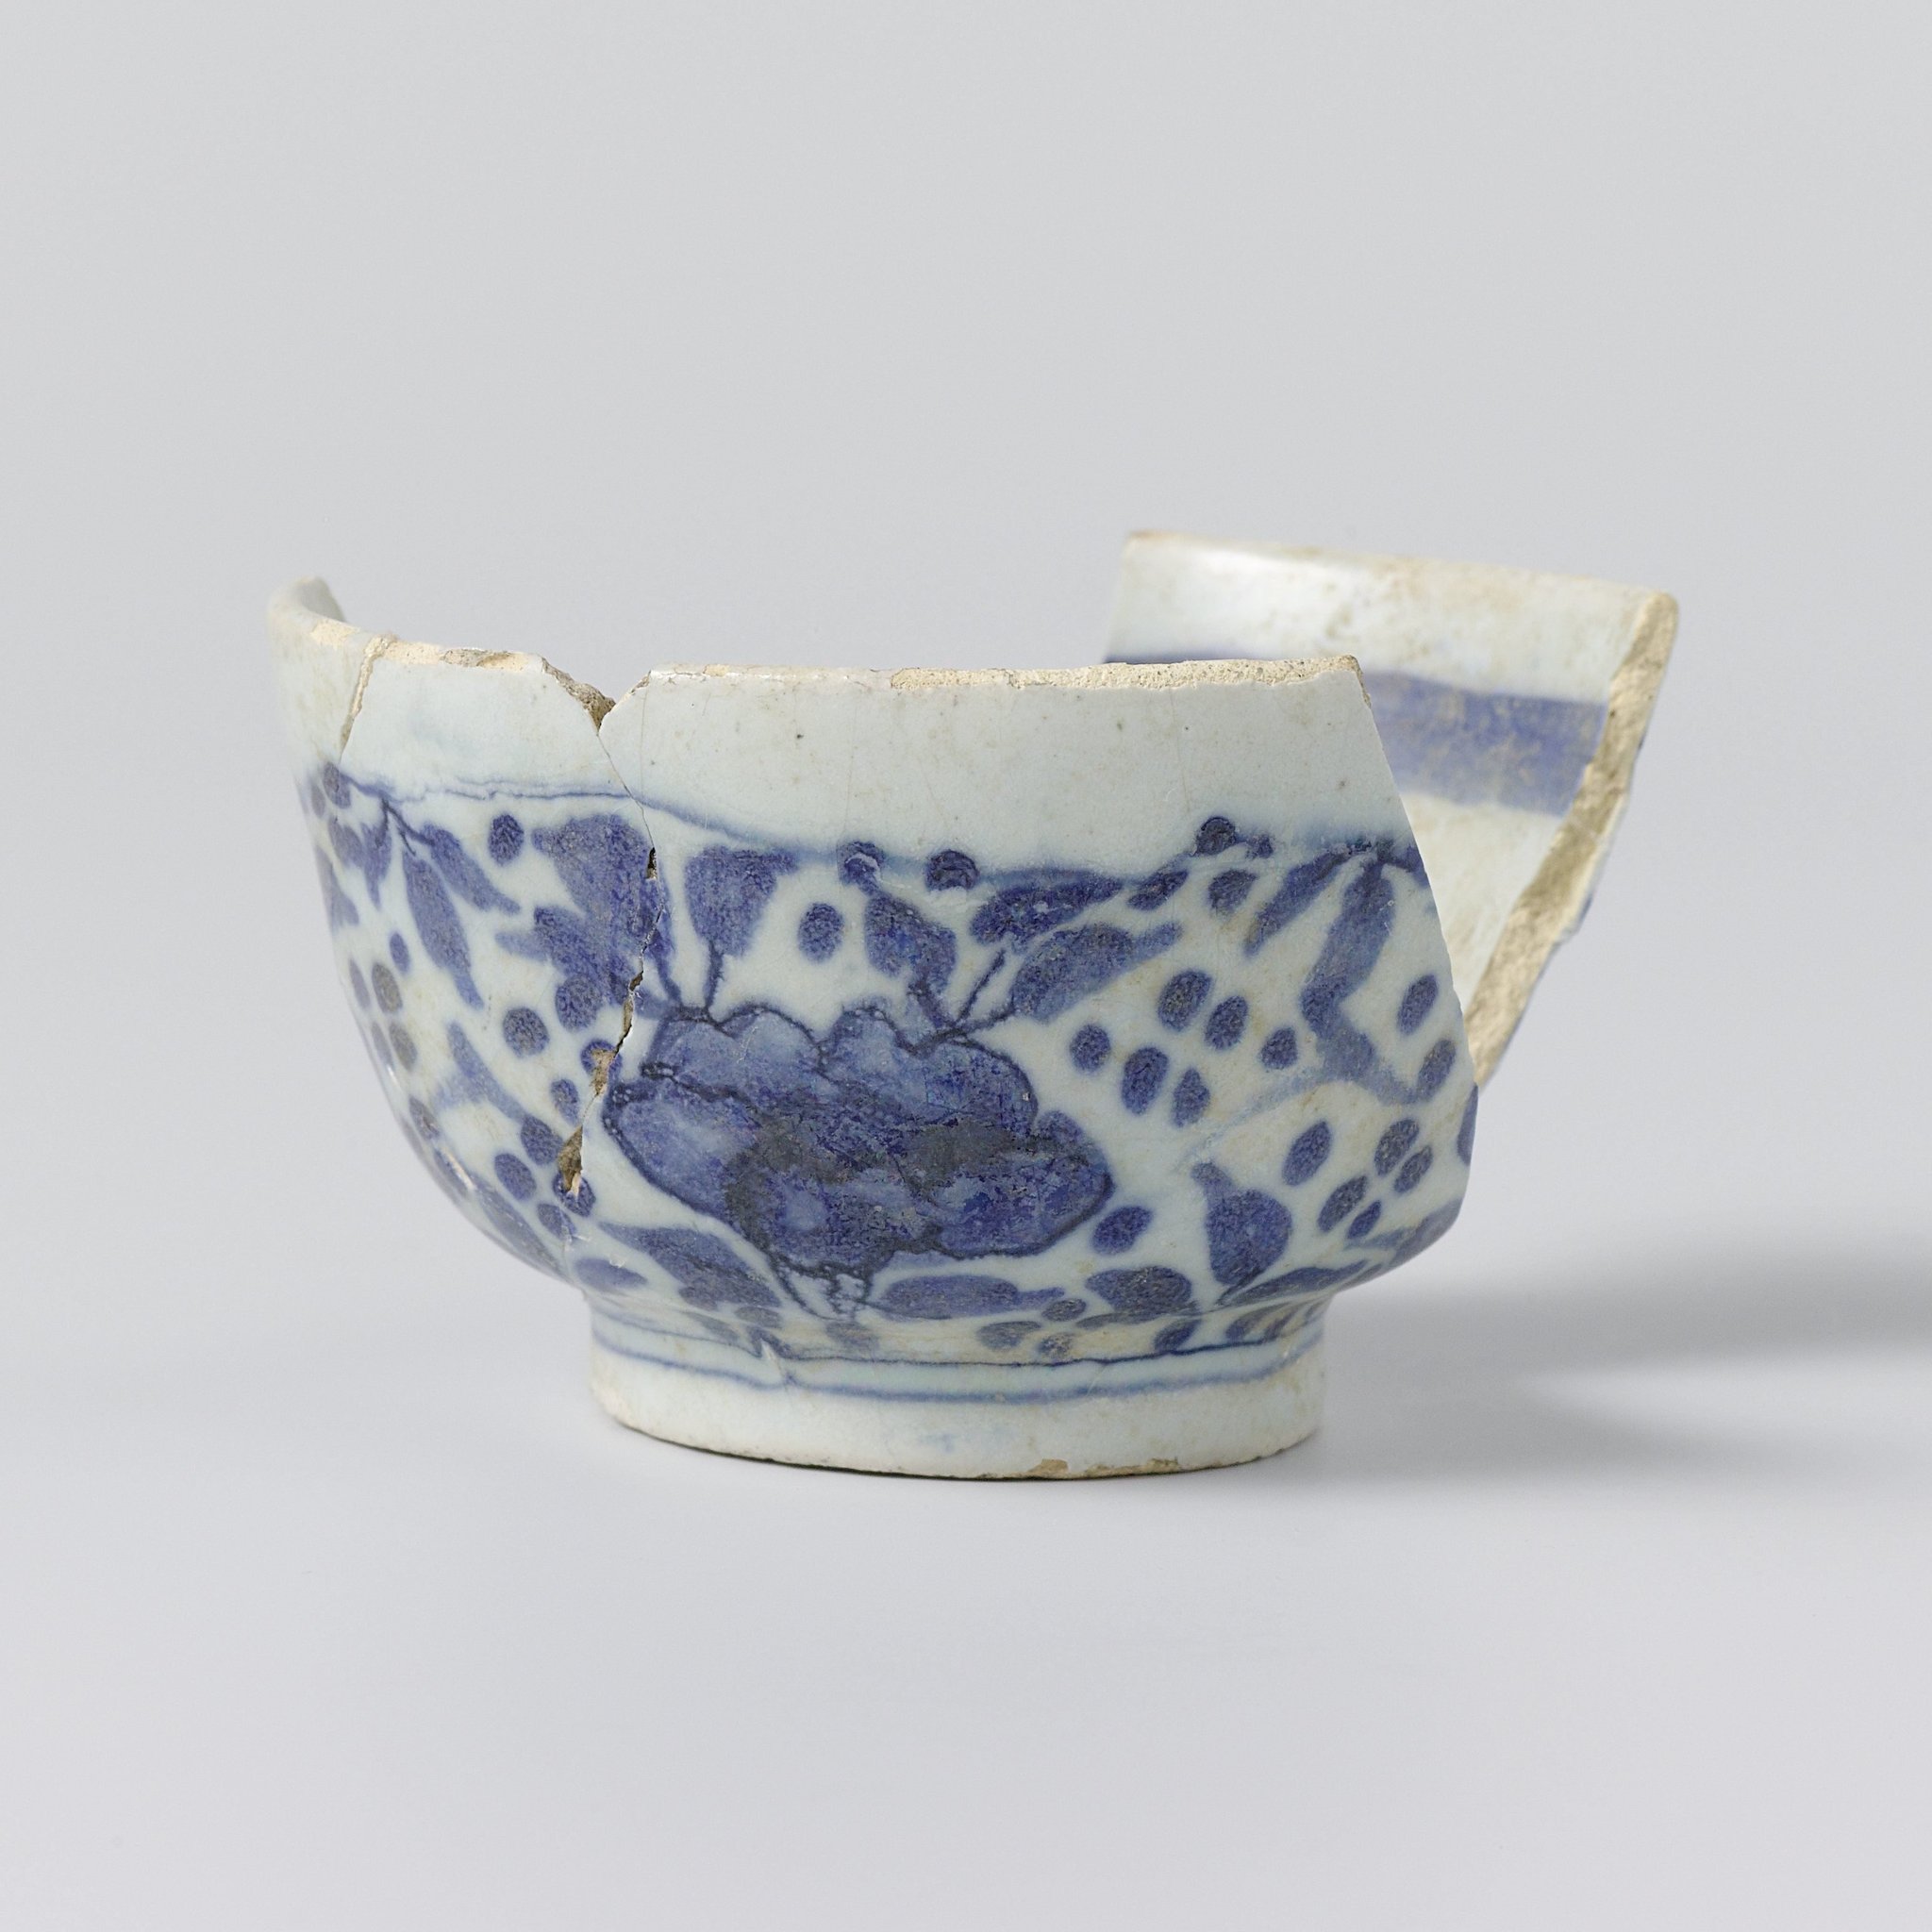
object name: fragment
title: Kop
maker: Anonymous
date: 1660-1730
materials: earthenware, glaze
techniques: painted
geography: delft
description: Kop van blauw beschilderde faience, beschilderd met grote bloemen, waartussen bladeren en vlekken. De kop is een bodemvondst.